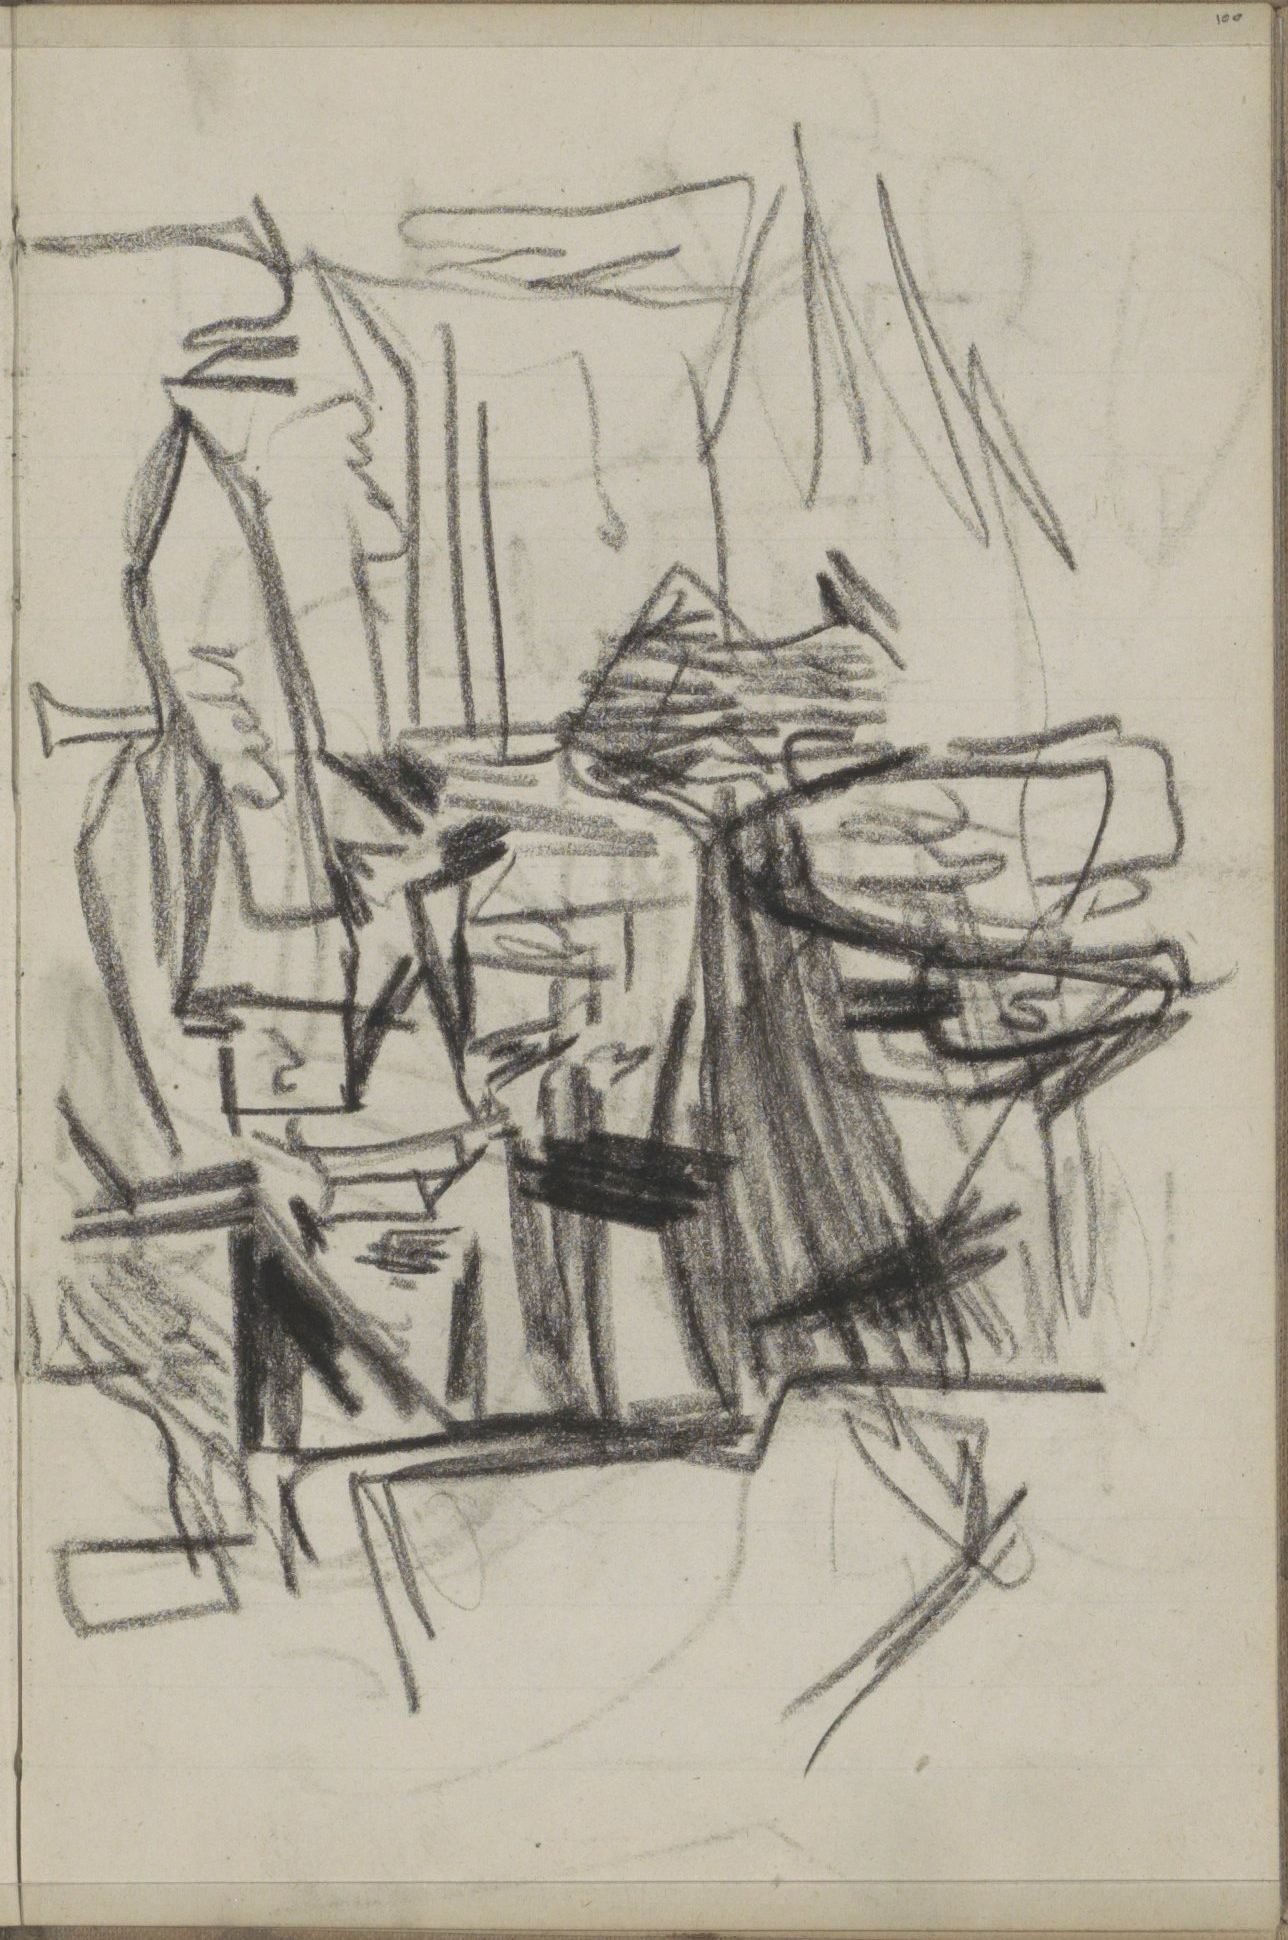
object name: sketchbook leaf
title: Figuren in een straat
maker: marius bauer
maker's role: draughtsman, print maker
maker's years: 1867-1932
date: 1888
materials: chalk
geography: istanbul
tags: street (+ city(-scape) with figures, staffage)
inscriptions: kleurnotitie, handgeschreven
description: Pagina 100 uit een schetsboek met 56 bladen.